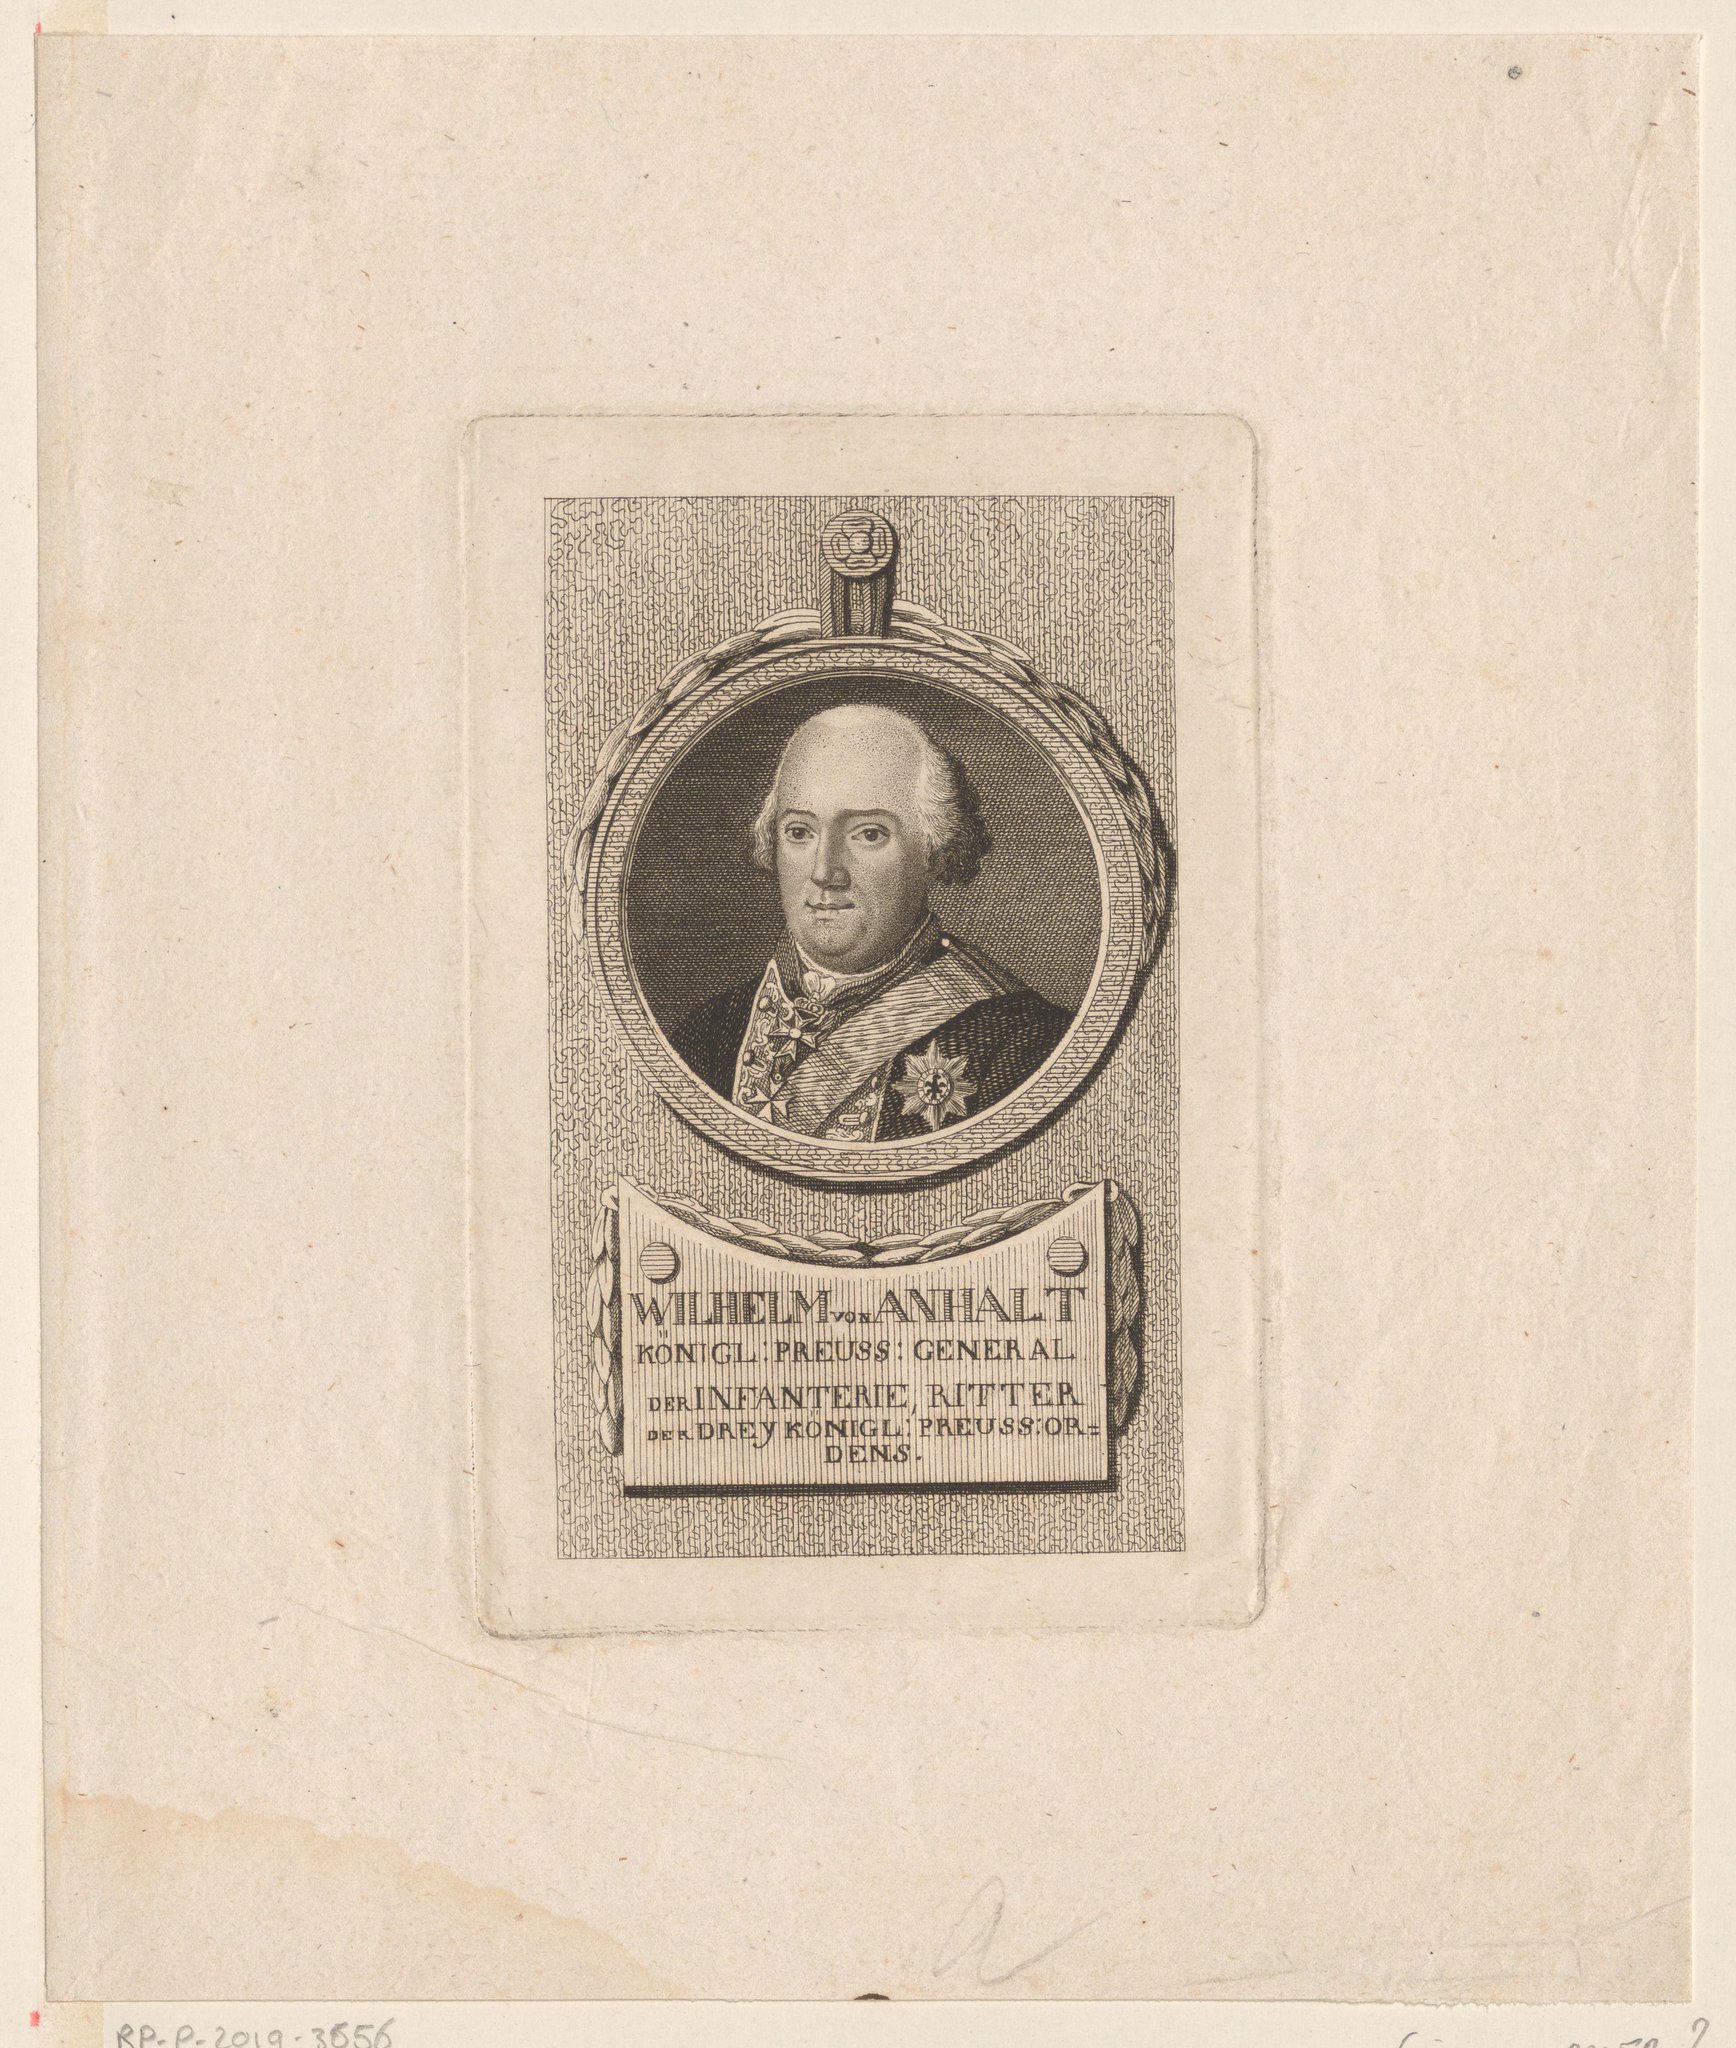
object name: print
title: Portret van Heinrich Wilhelm von Anhalt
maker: Anonymous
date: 1786-1799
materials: paper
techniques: etching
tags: ornament ~ medallion, historical persons